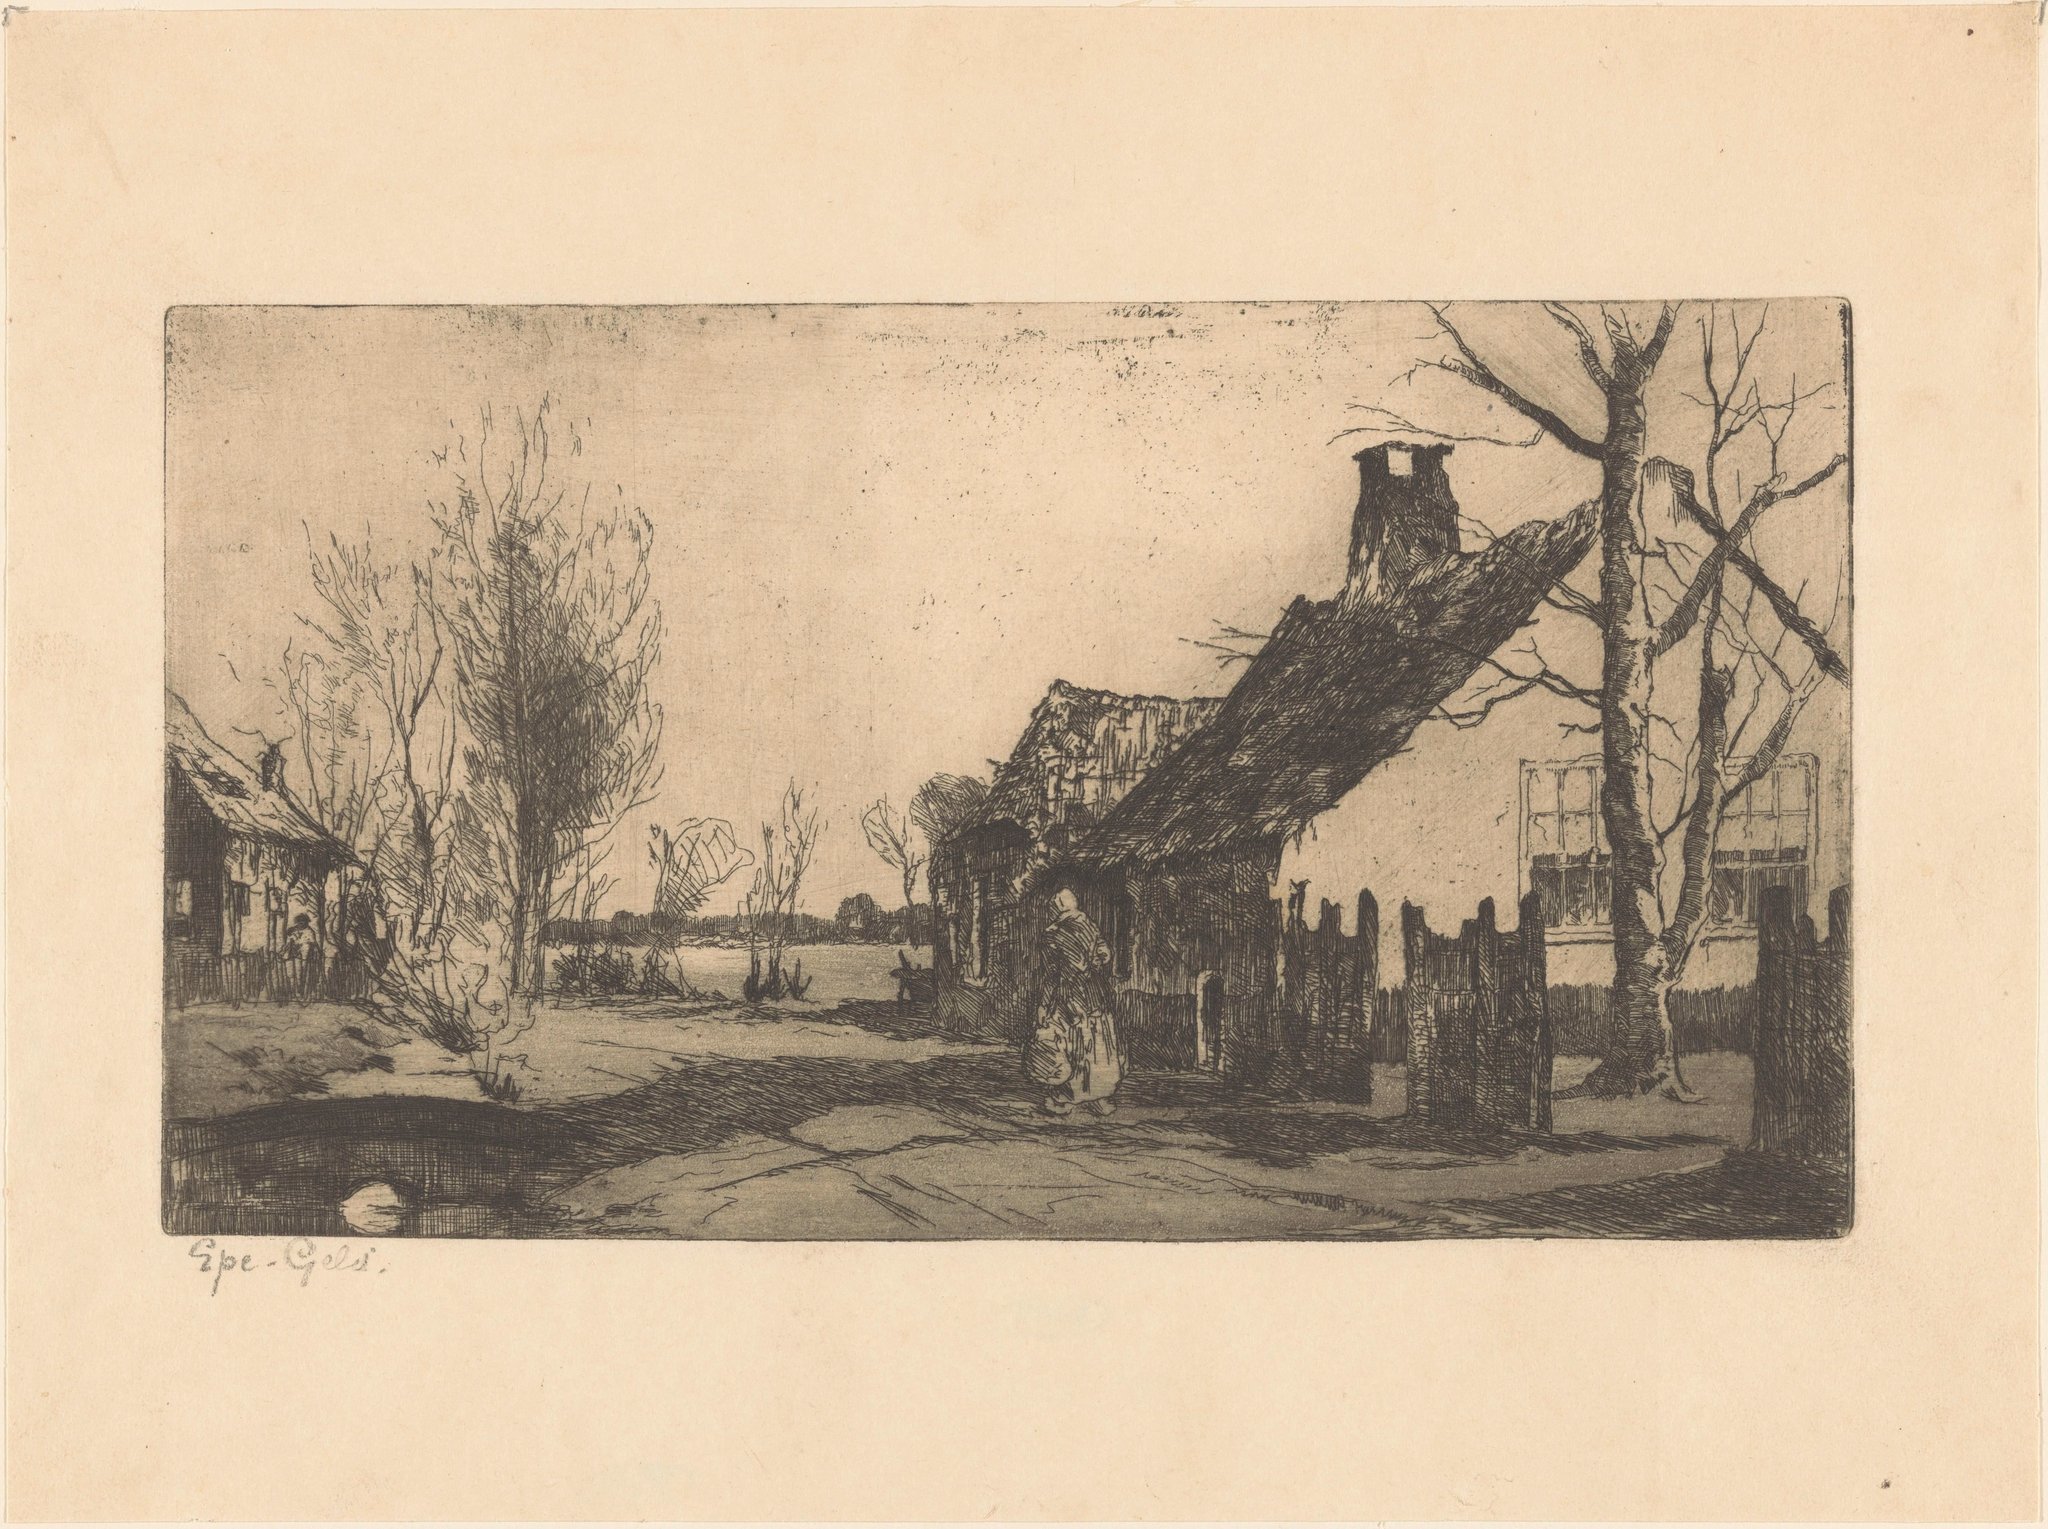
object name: print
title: Epe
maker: willem adrianus grondhout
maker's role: draughtsman, painter, print maker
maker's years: 1878-1934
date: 1888-1934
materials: paper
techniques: aquatint, etching, intaglio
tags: road, path, farm (building)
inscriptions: collector's mark: Lugt 2228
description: Een vrouw wandelt op een straat bij twee boerderijen.